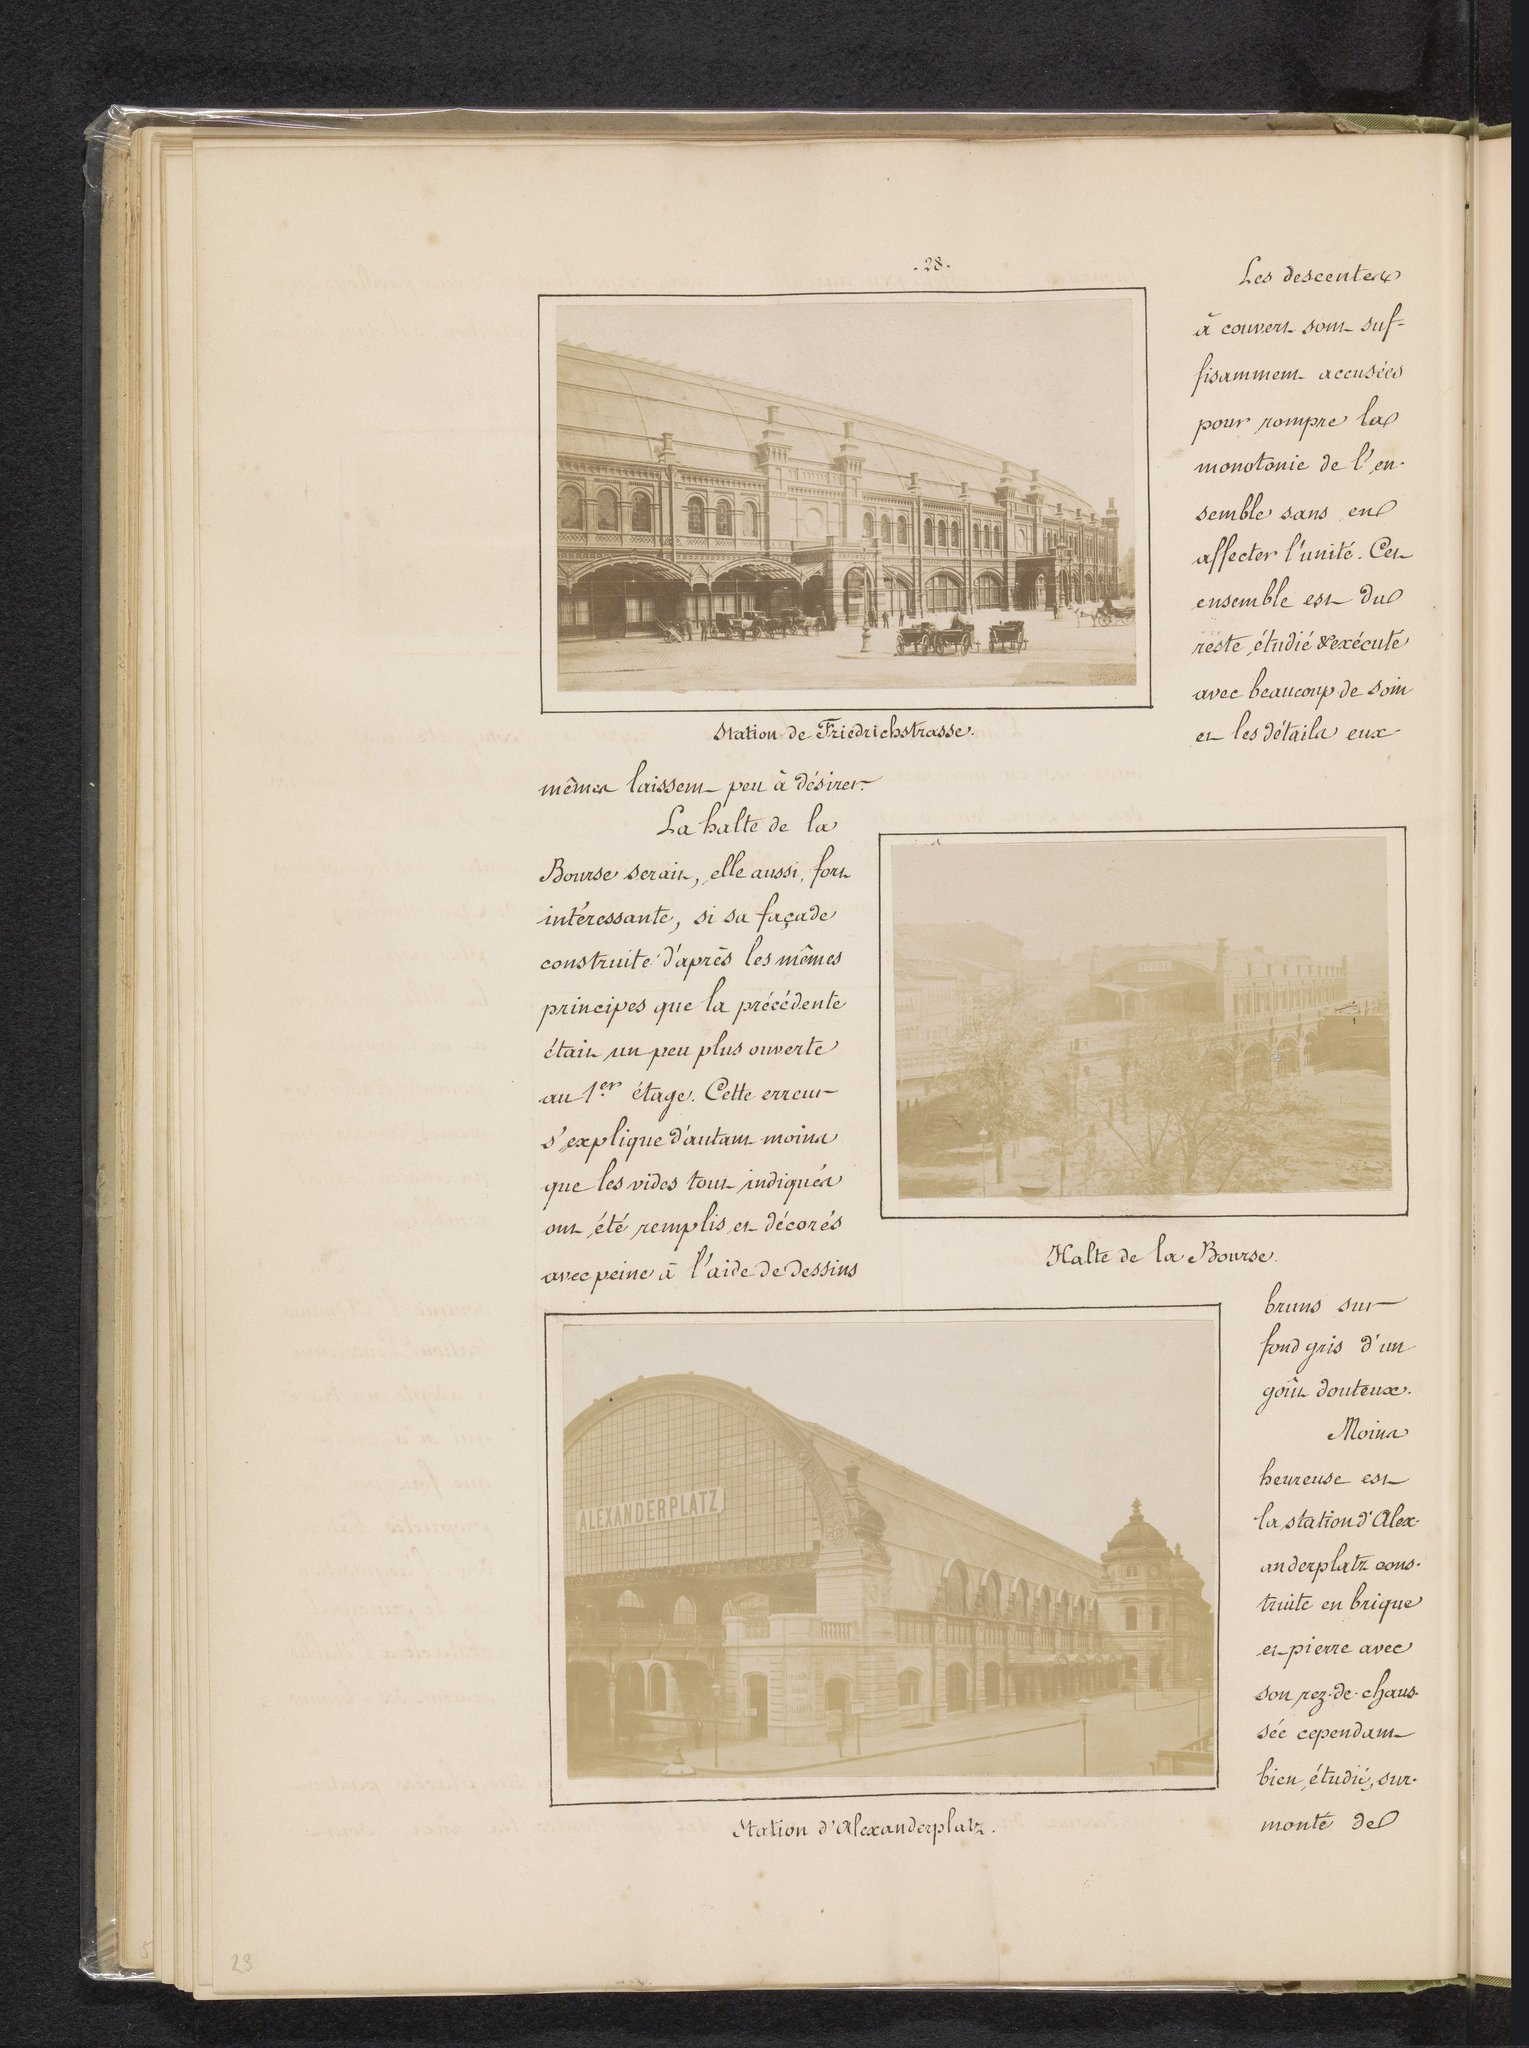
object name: photograph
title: Halte de la Bourse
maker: Anonymous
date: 1874-1884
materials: photographic support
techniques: albumen print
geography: berlin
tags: railway, train, interior ~ representation of a building, station; shelter (railway, tramway)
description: Boven het station aan de Friedrichstrasse, midden de halte aan de Börse, onder het station aan de Alexanderplatz.